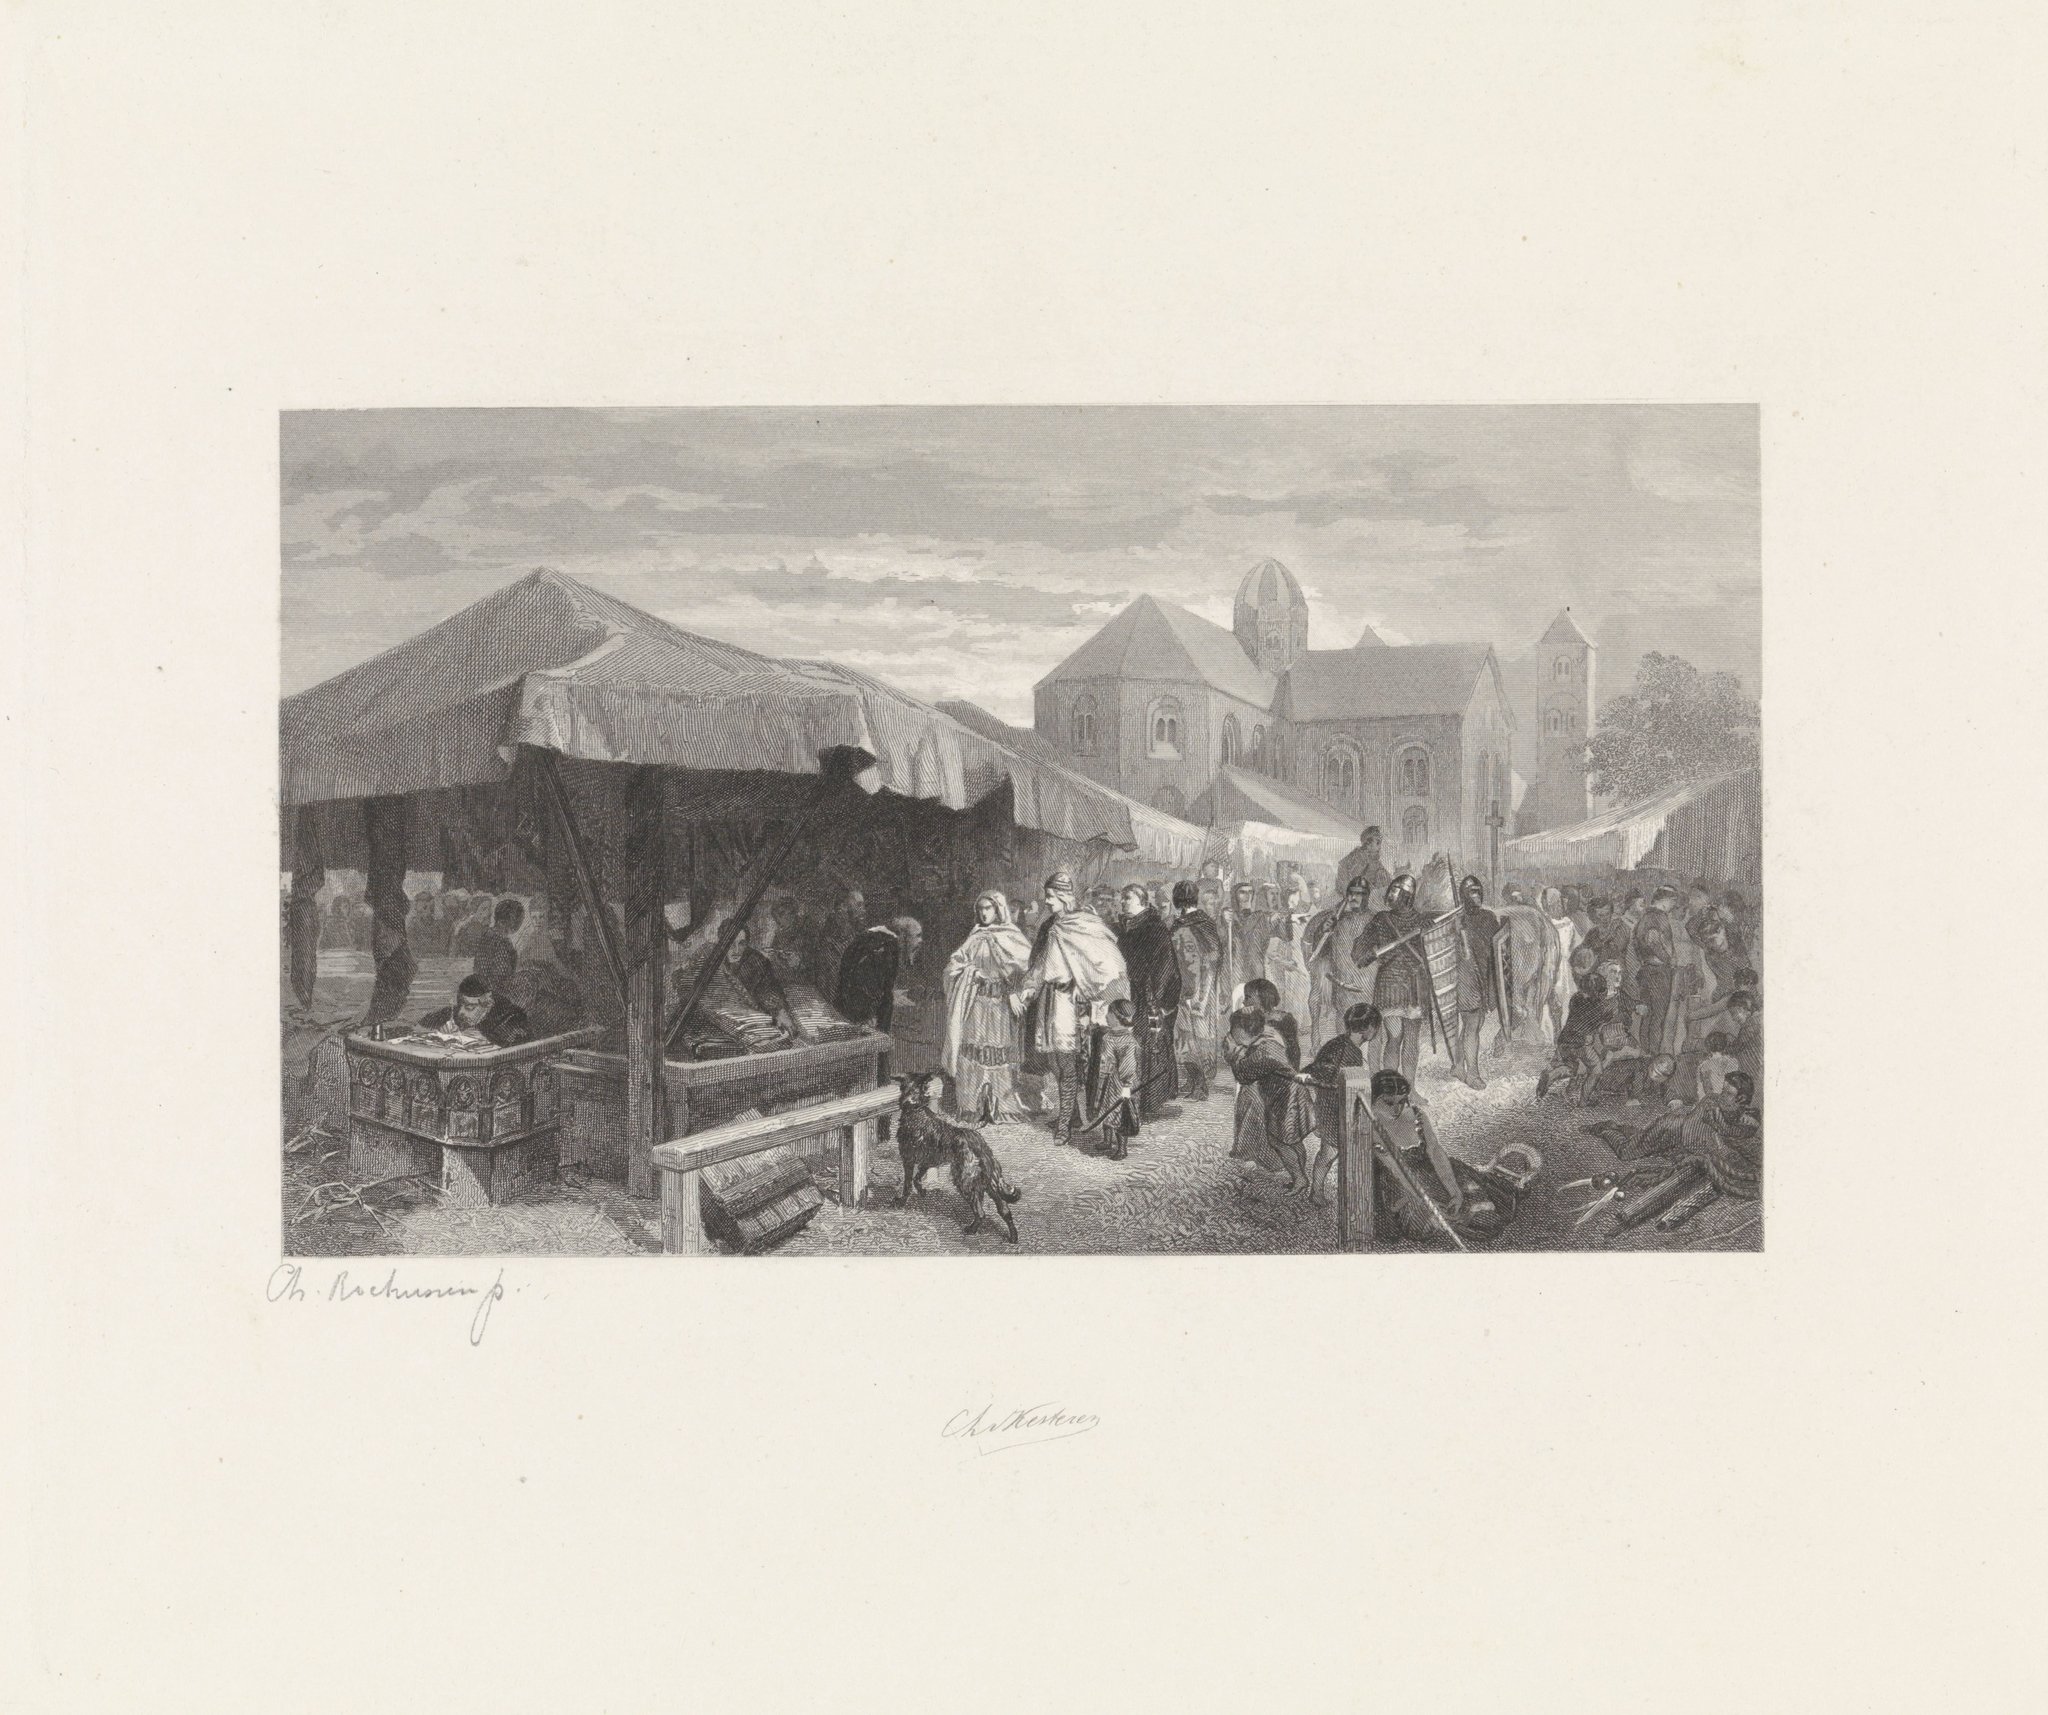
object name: print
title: Jaarmarkt te Utrecht begin 12e eeuw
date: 1865-1870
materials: paper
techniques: engraving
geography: netherlands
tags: market, utrecht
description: Illustratie voor: J. van Lennep en W. Moll en J. ter Gouw, Nederlands geschiedenis en volksleven in schetsen, A.W. Sijthoff, Leiden ca. 1870. Staalgravures naar de schilderijen van de Historische Galerij der Maatschappij Arti en Amicitiae.